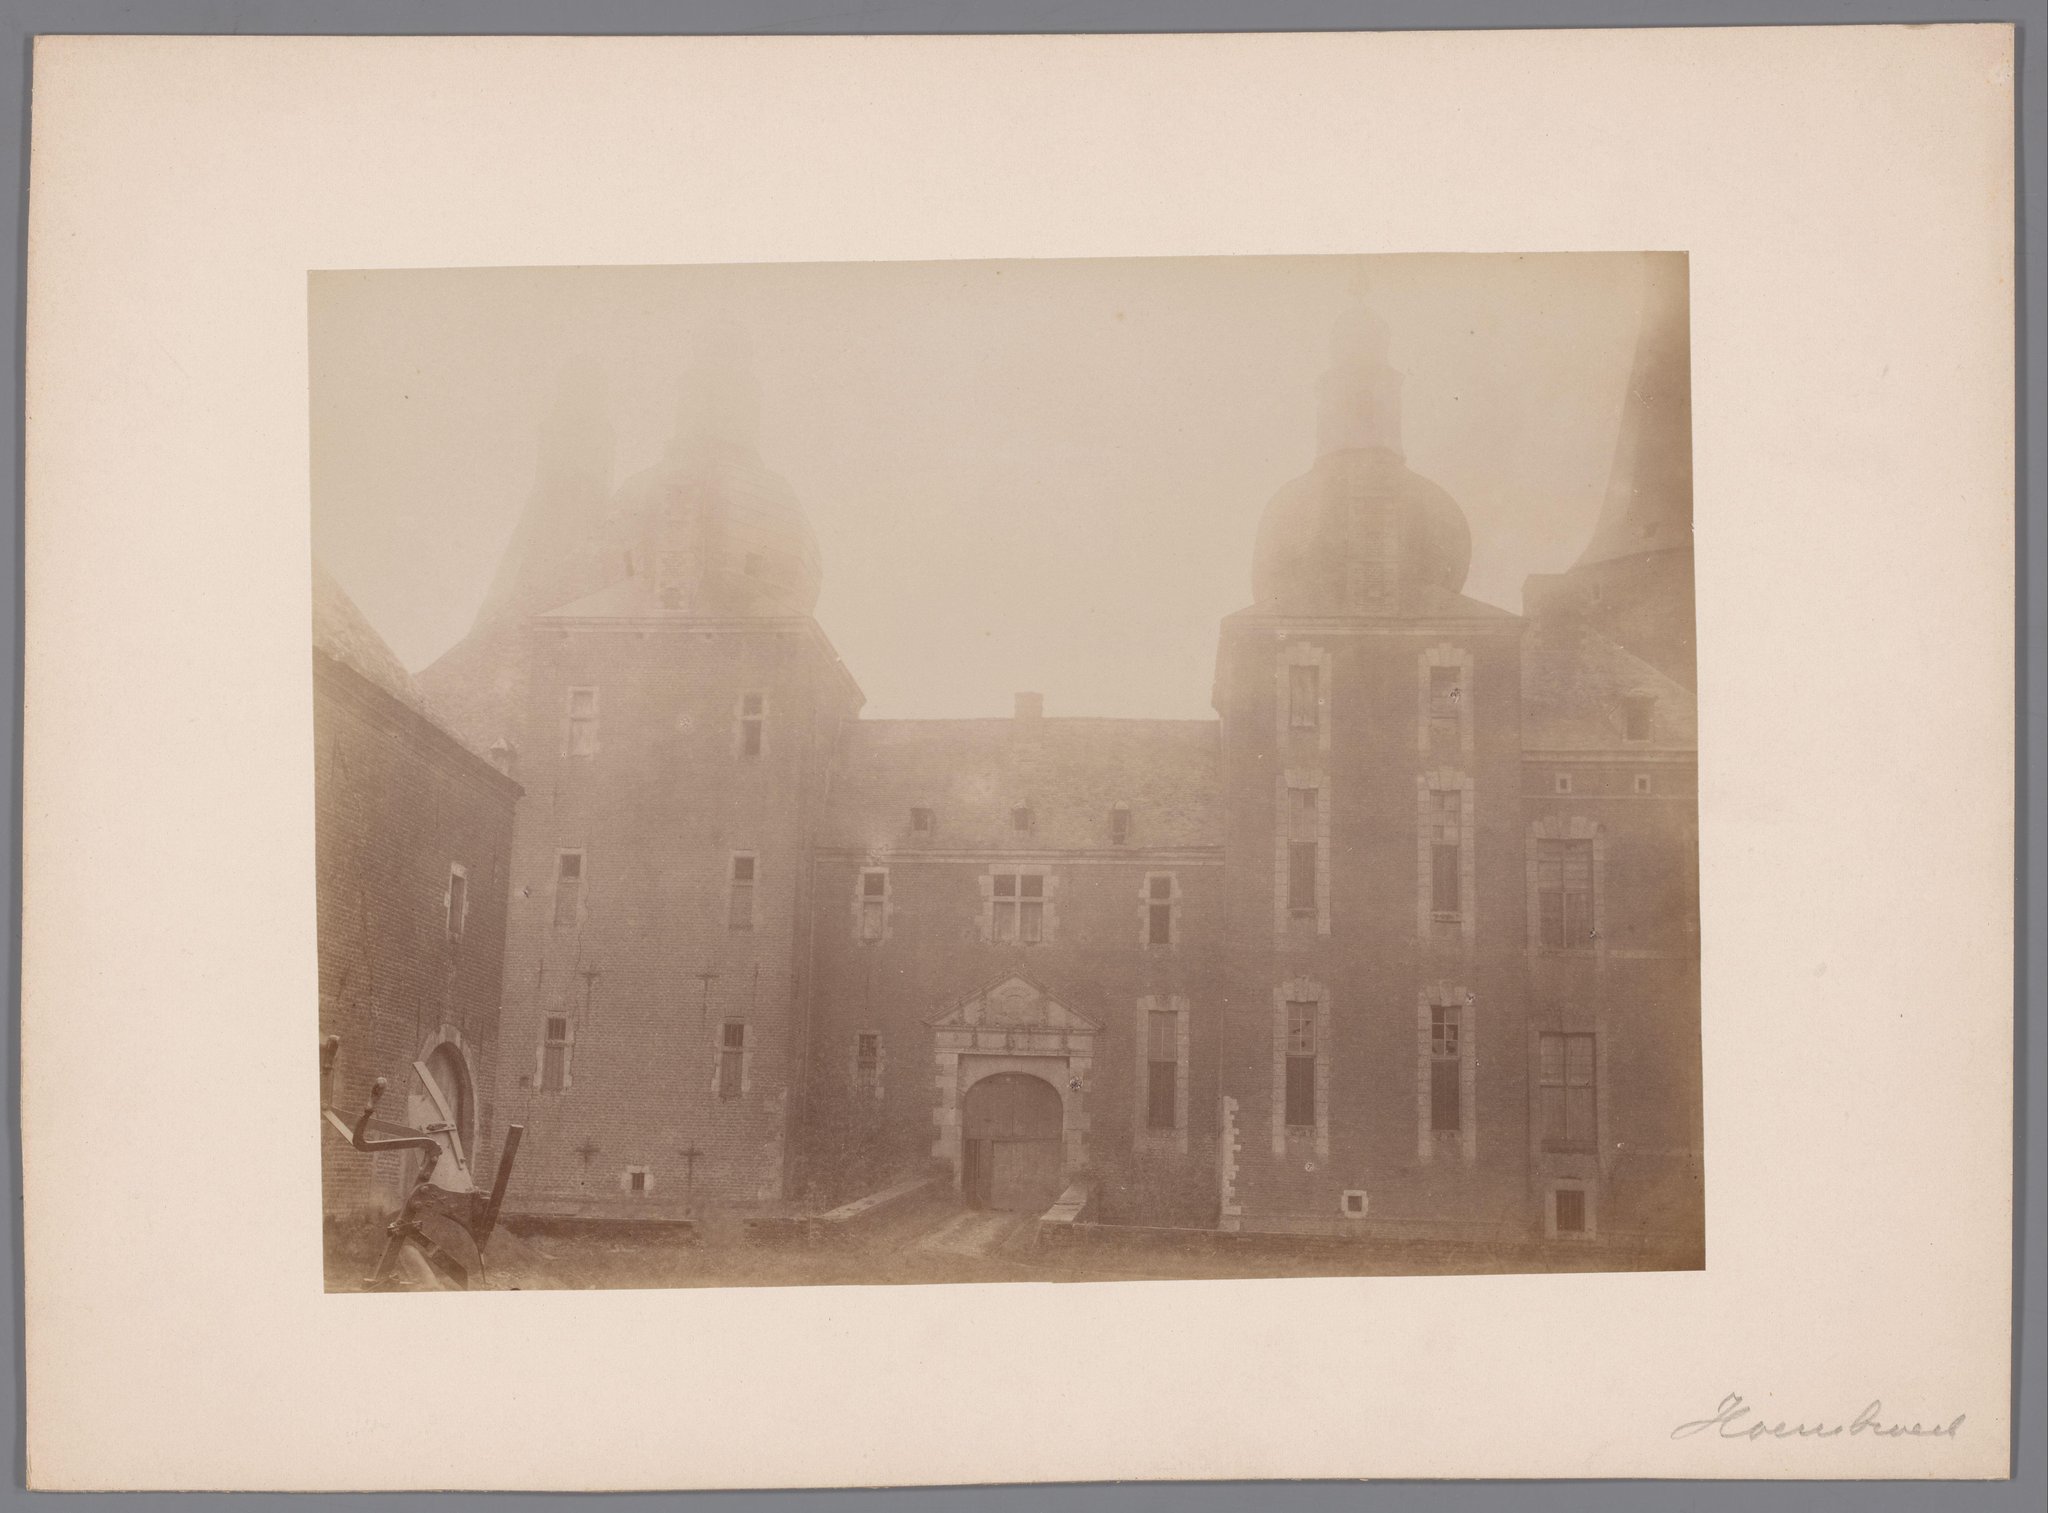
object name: photograph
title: Voorgevel van Kasteel Hoensbroek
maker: anoniem (monumentenzorg)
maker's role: fotograaf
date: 1903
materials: cardboard, photographic support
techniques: albumen print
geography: hoensbroek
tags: castle, façade (of house or building)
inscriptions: annotation: ‘Hoensbroek’, annotation: ‘Hoensbroek (L.)/ kasteel/ nov 1903’